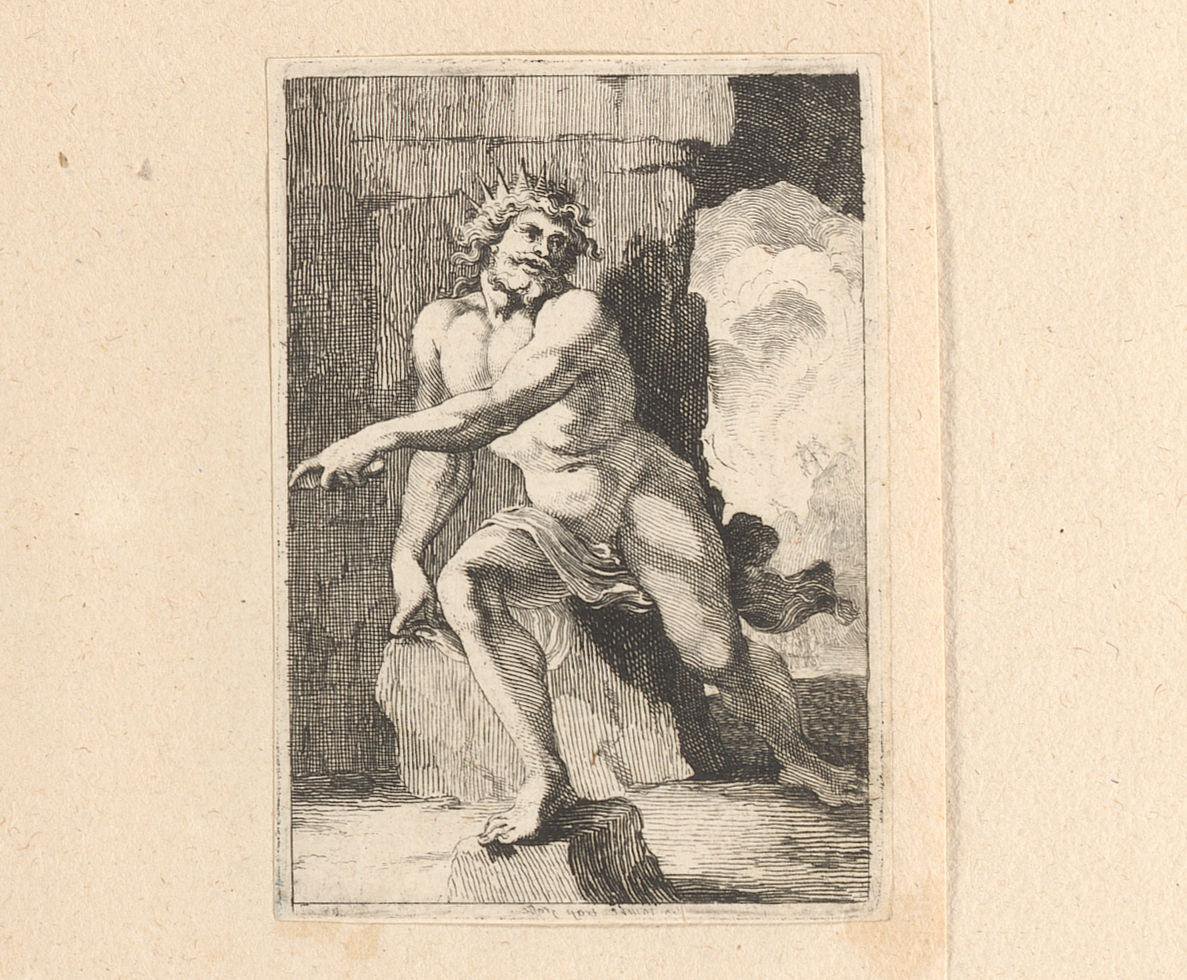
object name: print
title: Figures d'Academie pour apprendre à désiner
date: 1665-1673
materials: paper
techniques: etching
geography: paris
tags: model-books ~ implements of painter, (story of) pluto (hades), dis pater, orcus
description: Maakt deel uit van een 32-delige serie met tekenvoorbeelden van goden en helden uit de klassieke oudheid. Een eerste editie werd in 1673 uitgegeven en een tweede in 1684 door Nicolas Langlois.